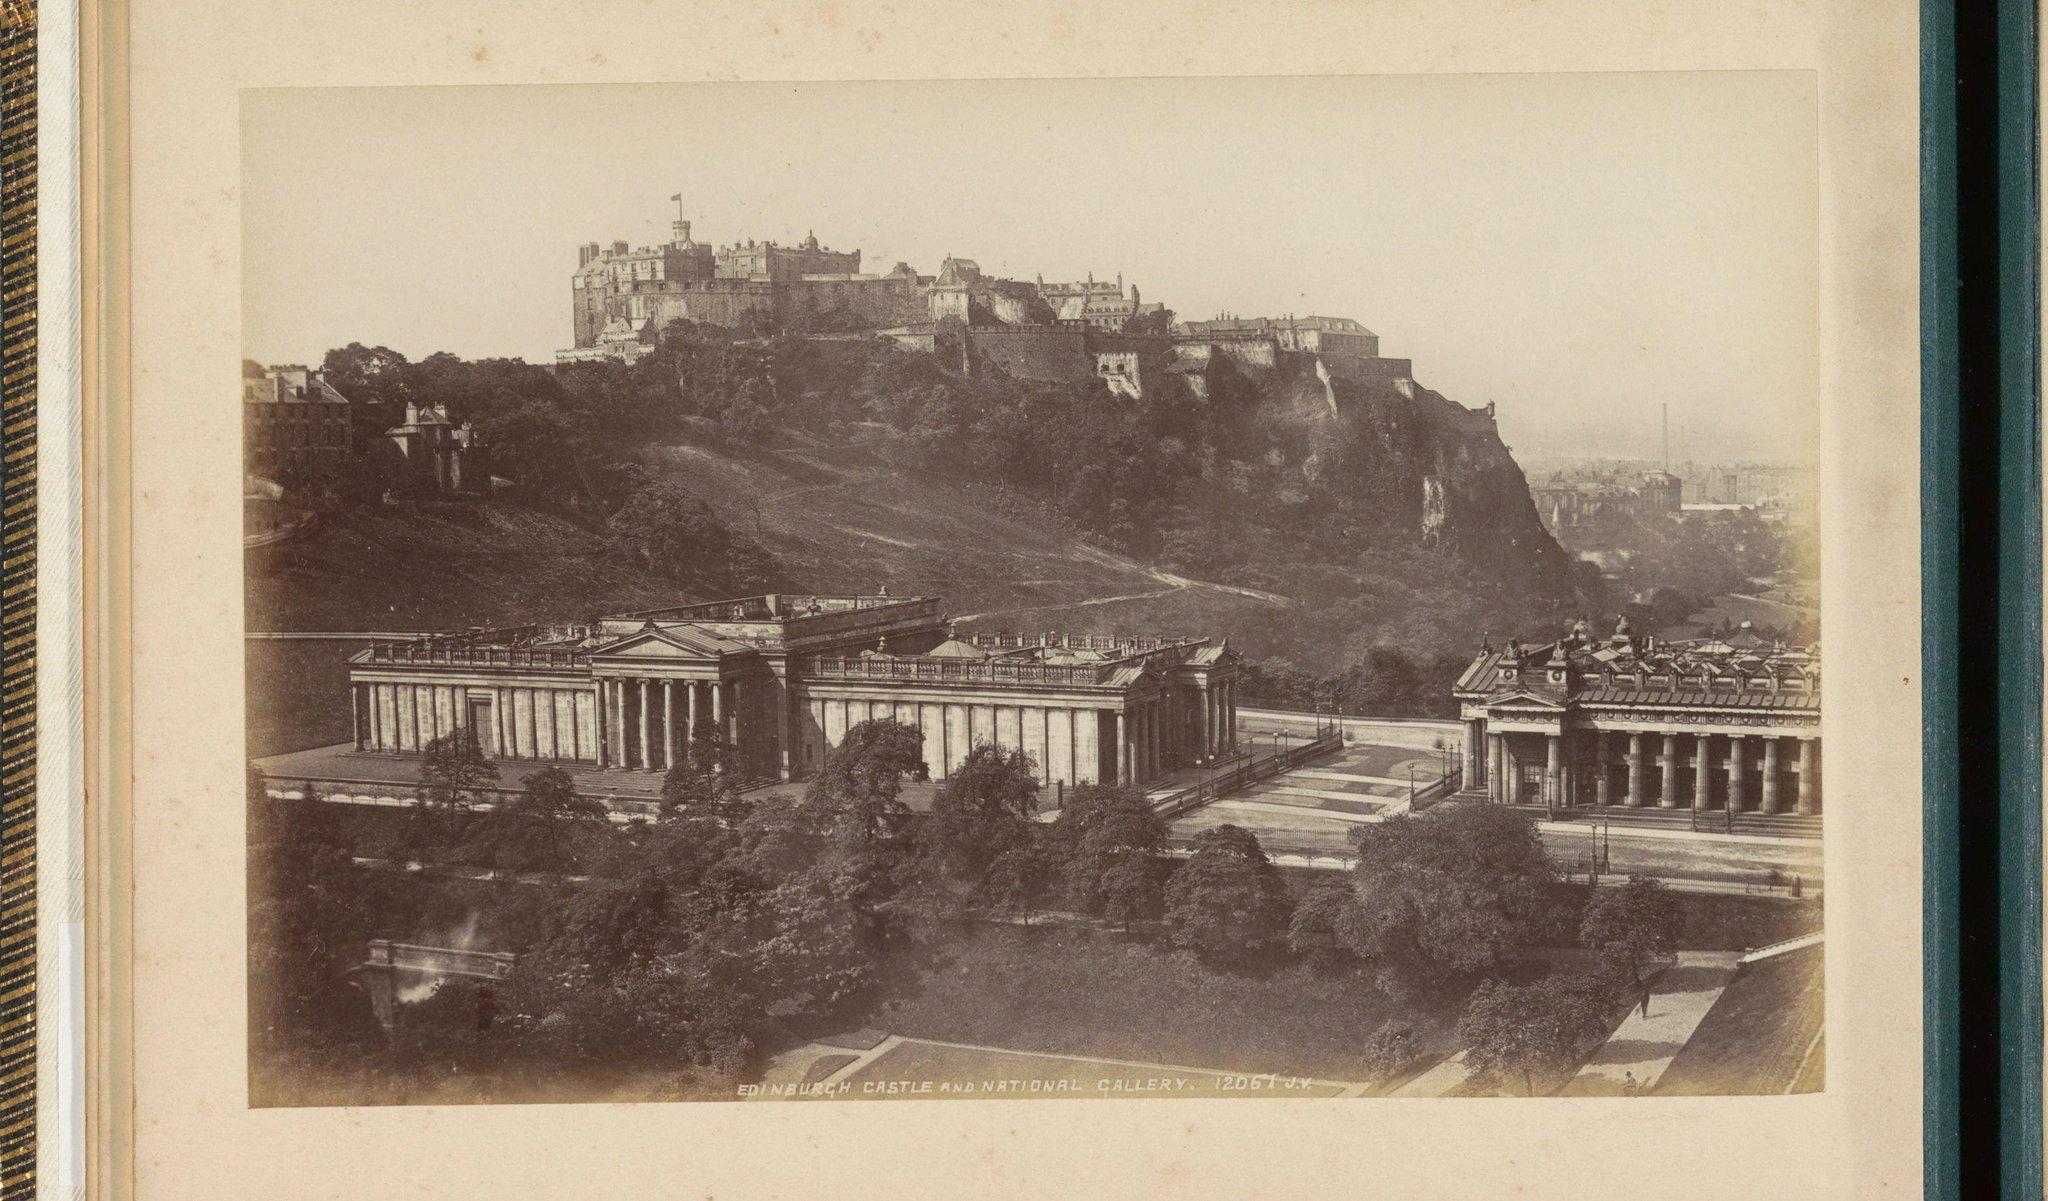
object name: photograph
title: Gezicht op Edinburgh Castle en de National Gallery in Edinburgh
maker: james valentine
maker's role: fotograaf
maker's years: 1815-1880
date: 1870-1890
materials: cardboard, photographic support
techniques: albumen print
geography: edinburgh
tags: castle, permanent exhibition, museum, prospect of city, town panorama, silhouette of city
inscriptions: number: ‘12067’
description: Onderdeel van Fotoalbum met bezienswaardigheden in Edinburgh en Londen.